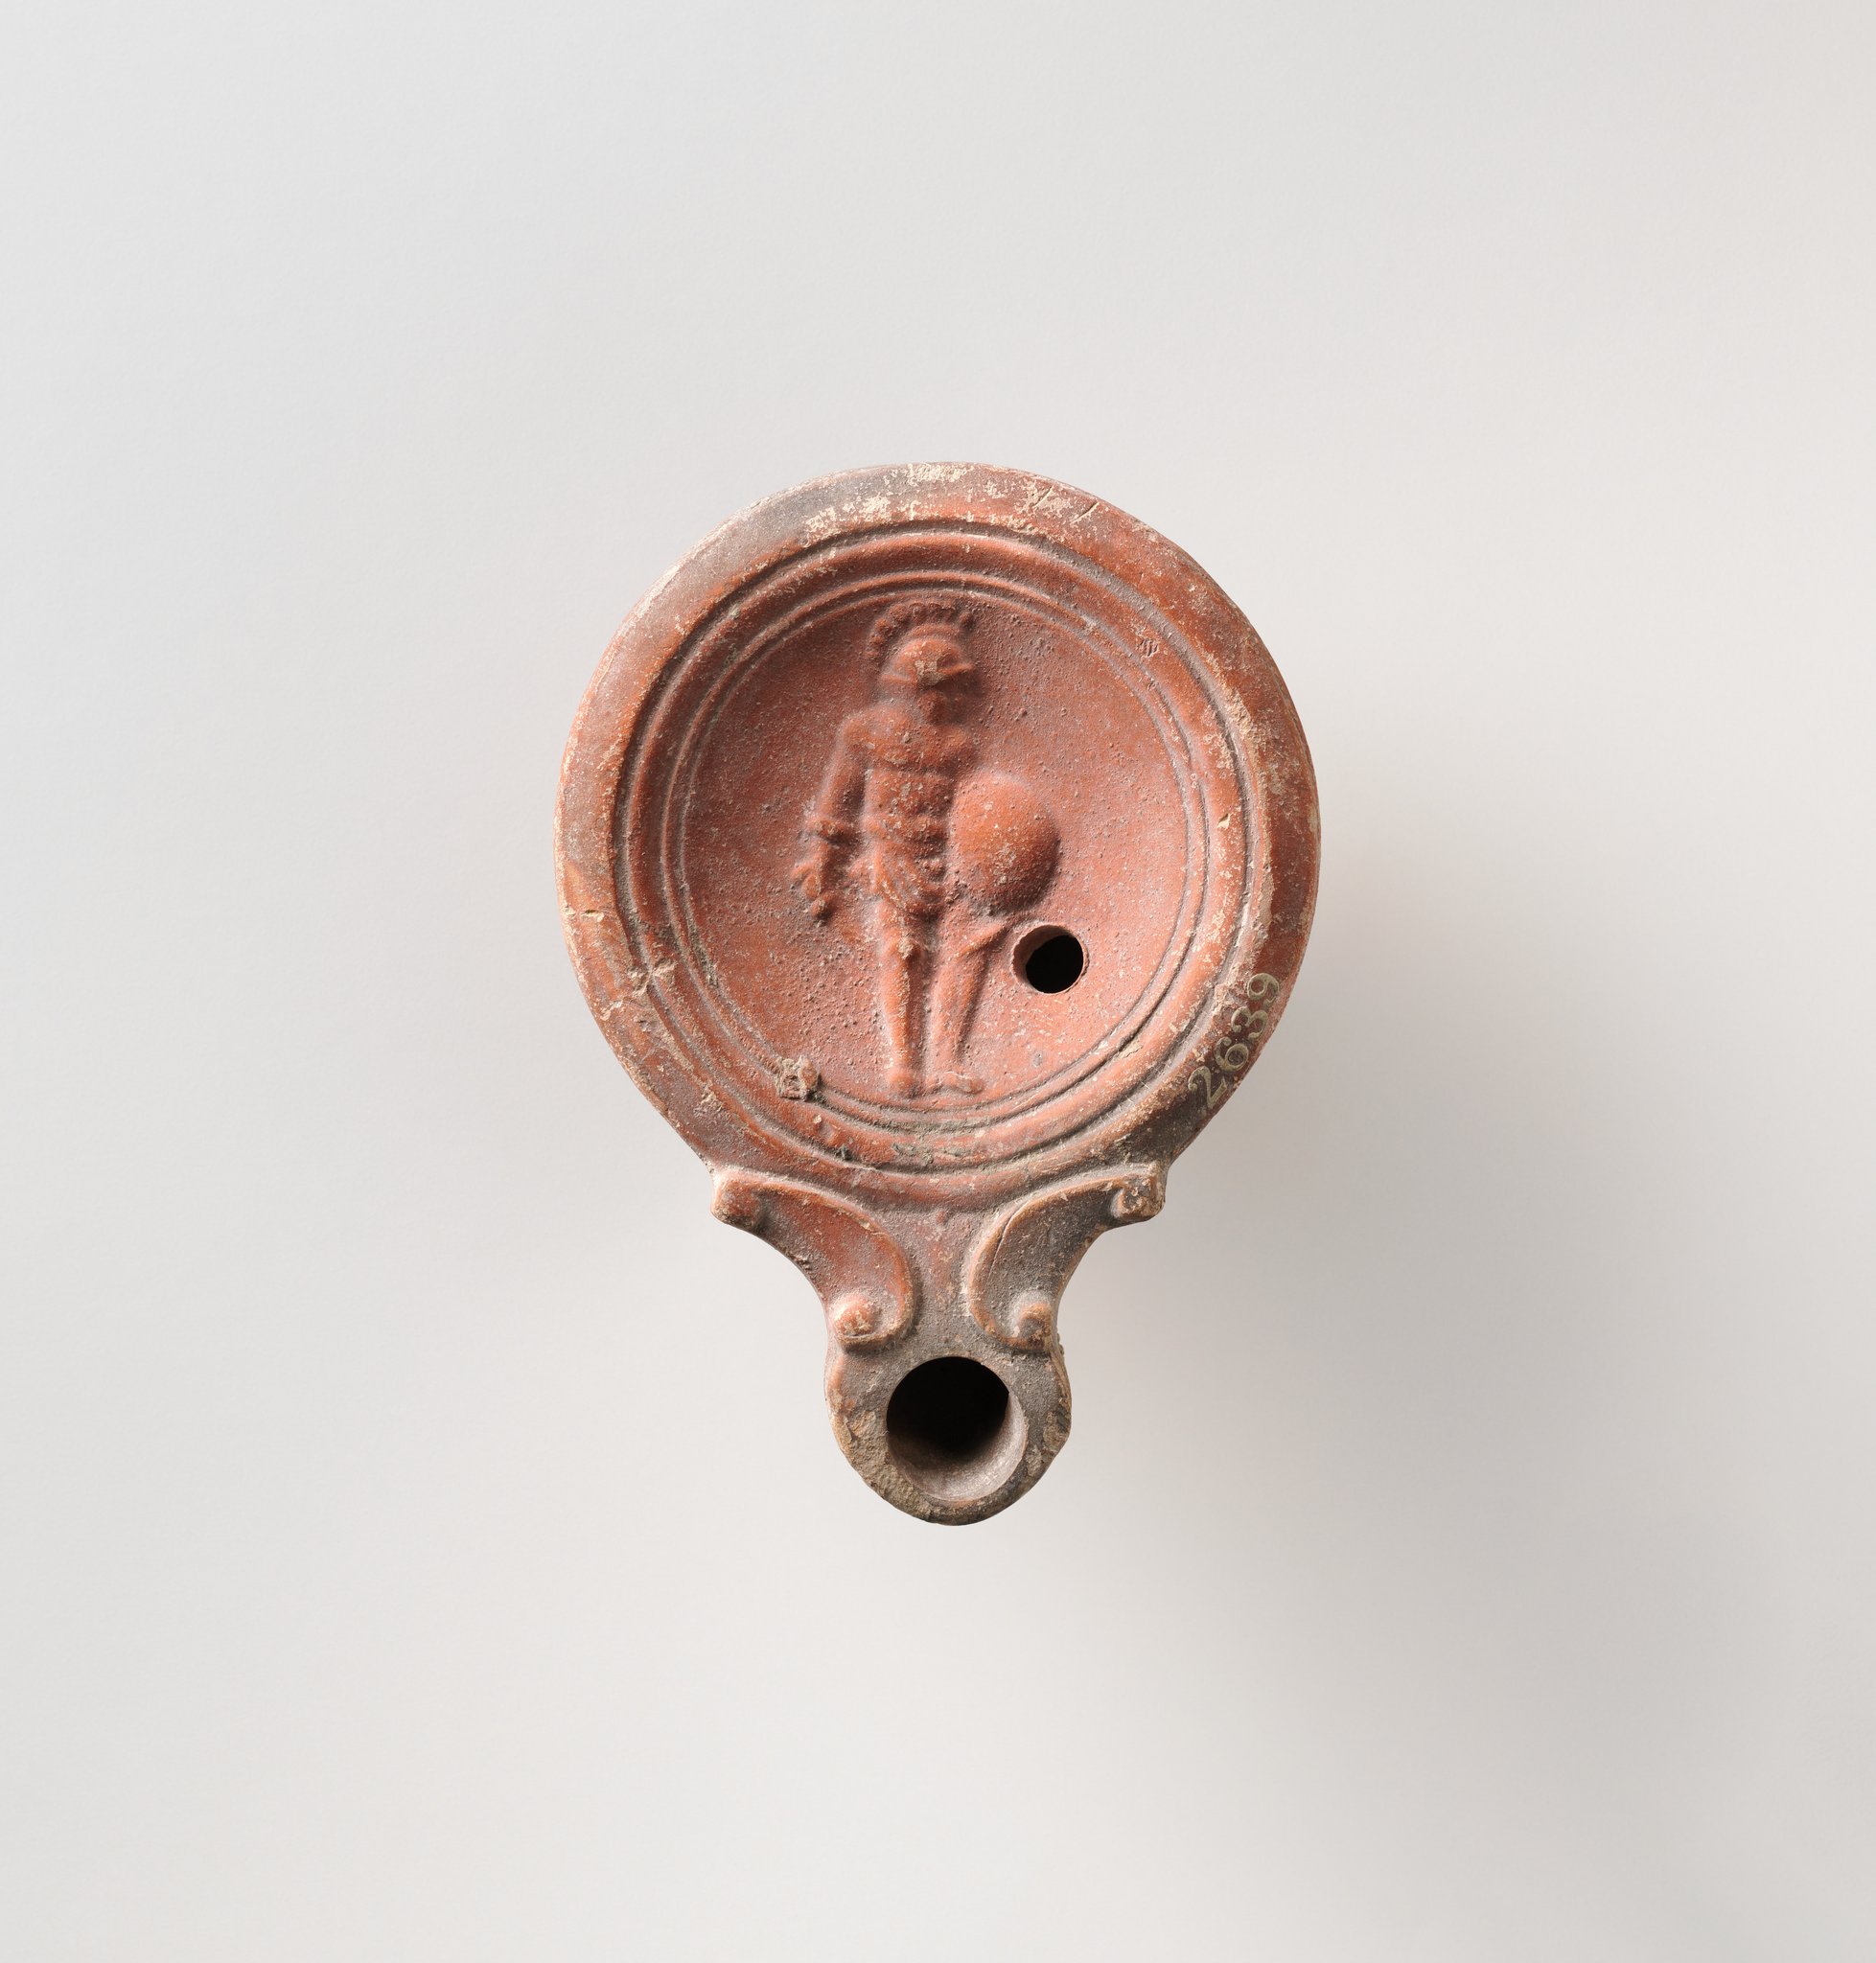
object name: lamp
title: Terracotta oil lamp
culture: roman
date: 34 BCE-33 CE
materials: terracotta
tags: gladiators